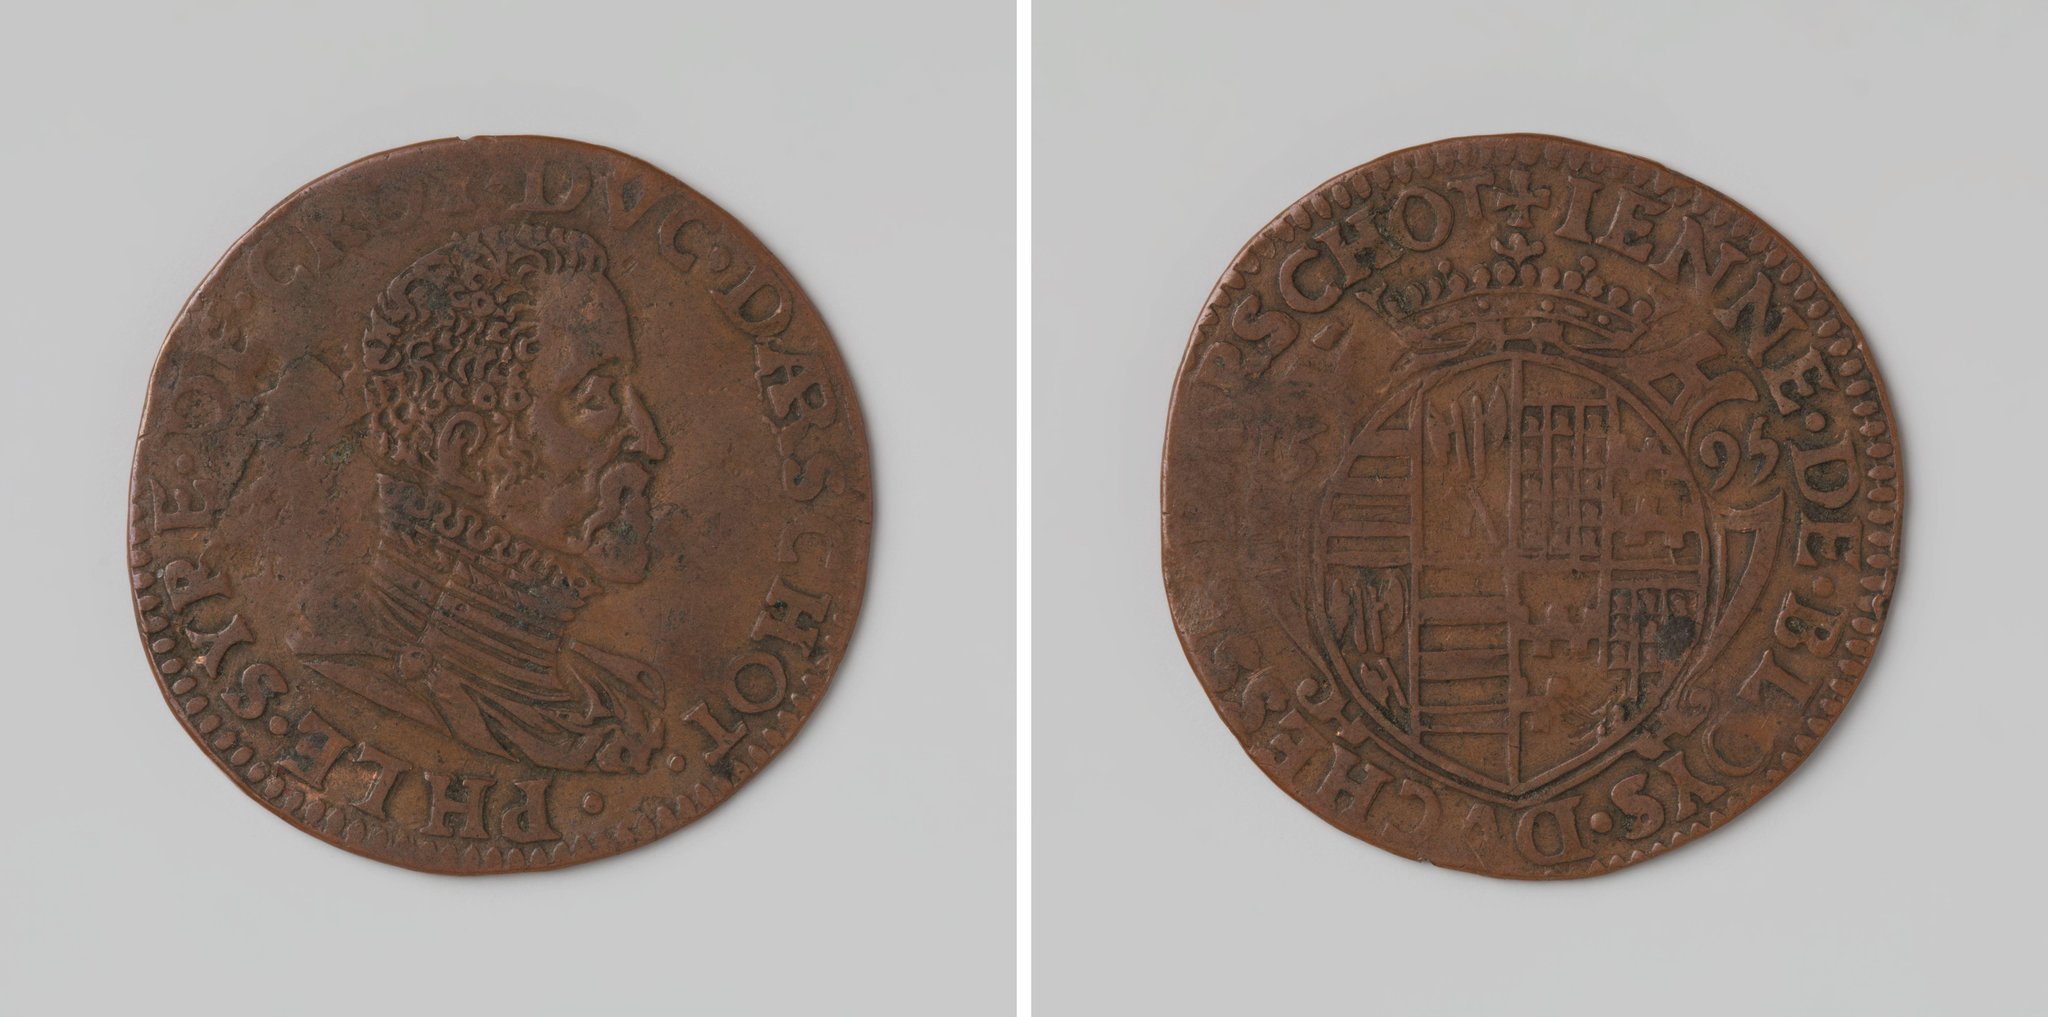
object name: jeton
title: Filips III van Croy, hertog van Aarschot en Johanna van Blois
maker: Anonymous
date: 1595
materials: copper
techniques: striking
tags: venice, earl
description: Koperen penning. Voorzijde: borststuk man binnen omschrift. Keerzijde: wapenschild in cartouche tussen jaartal onder kroon binnen omschrift